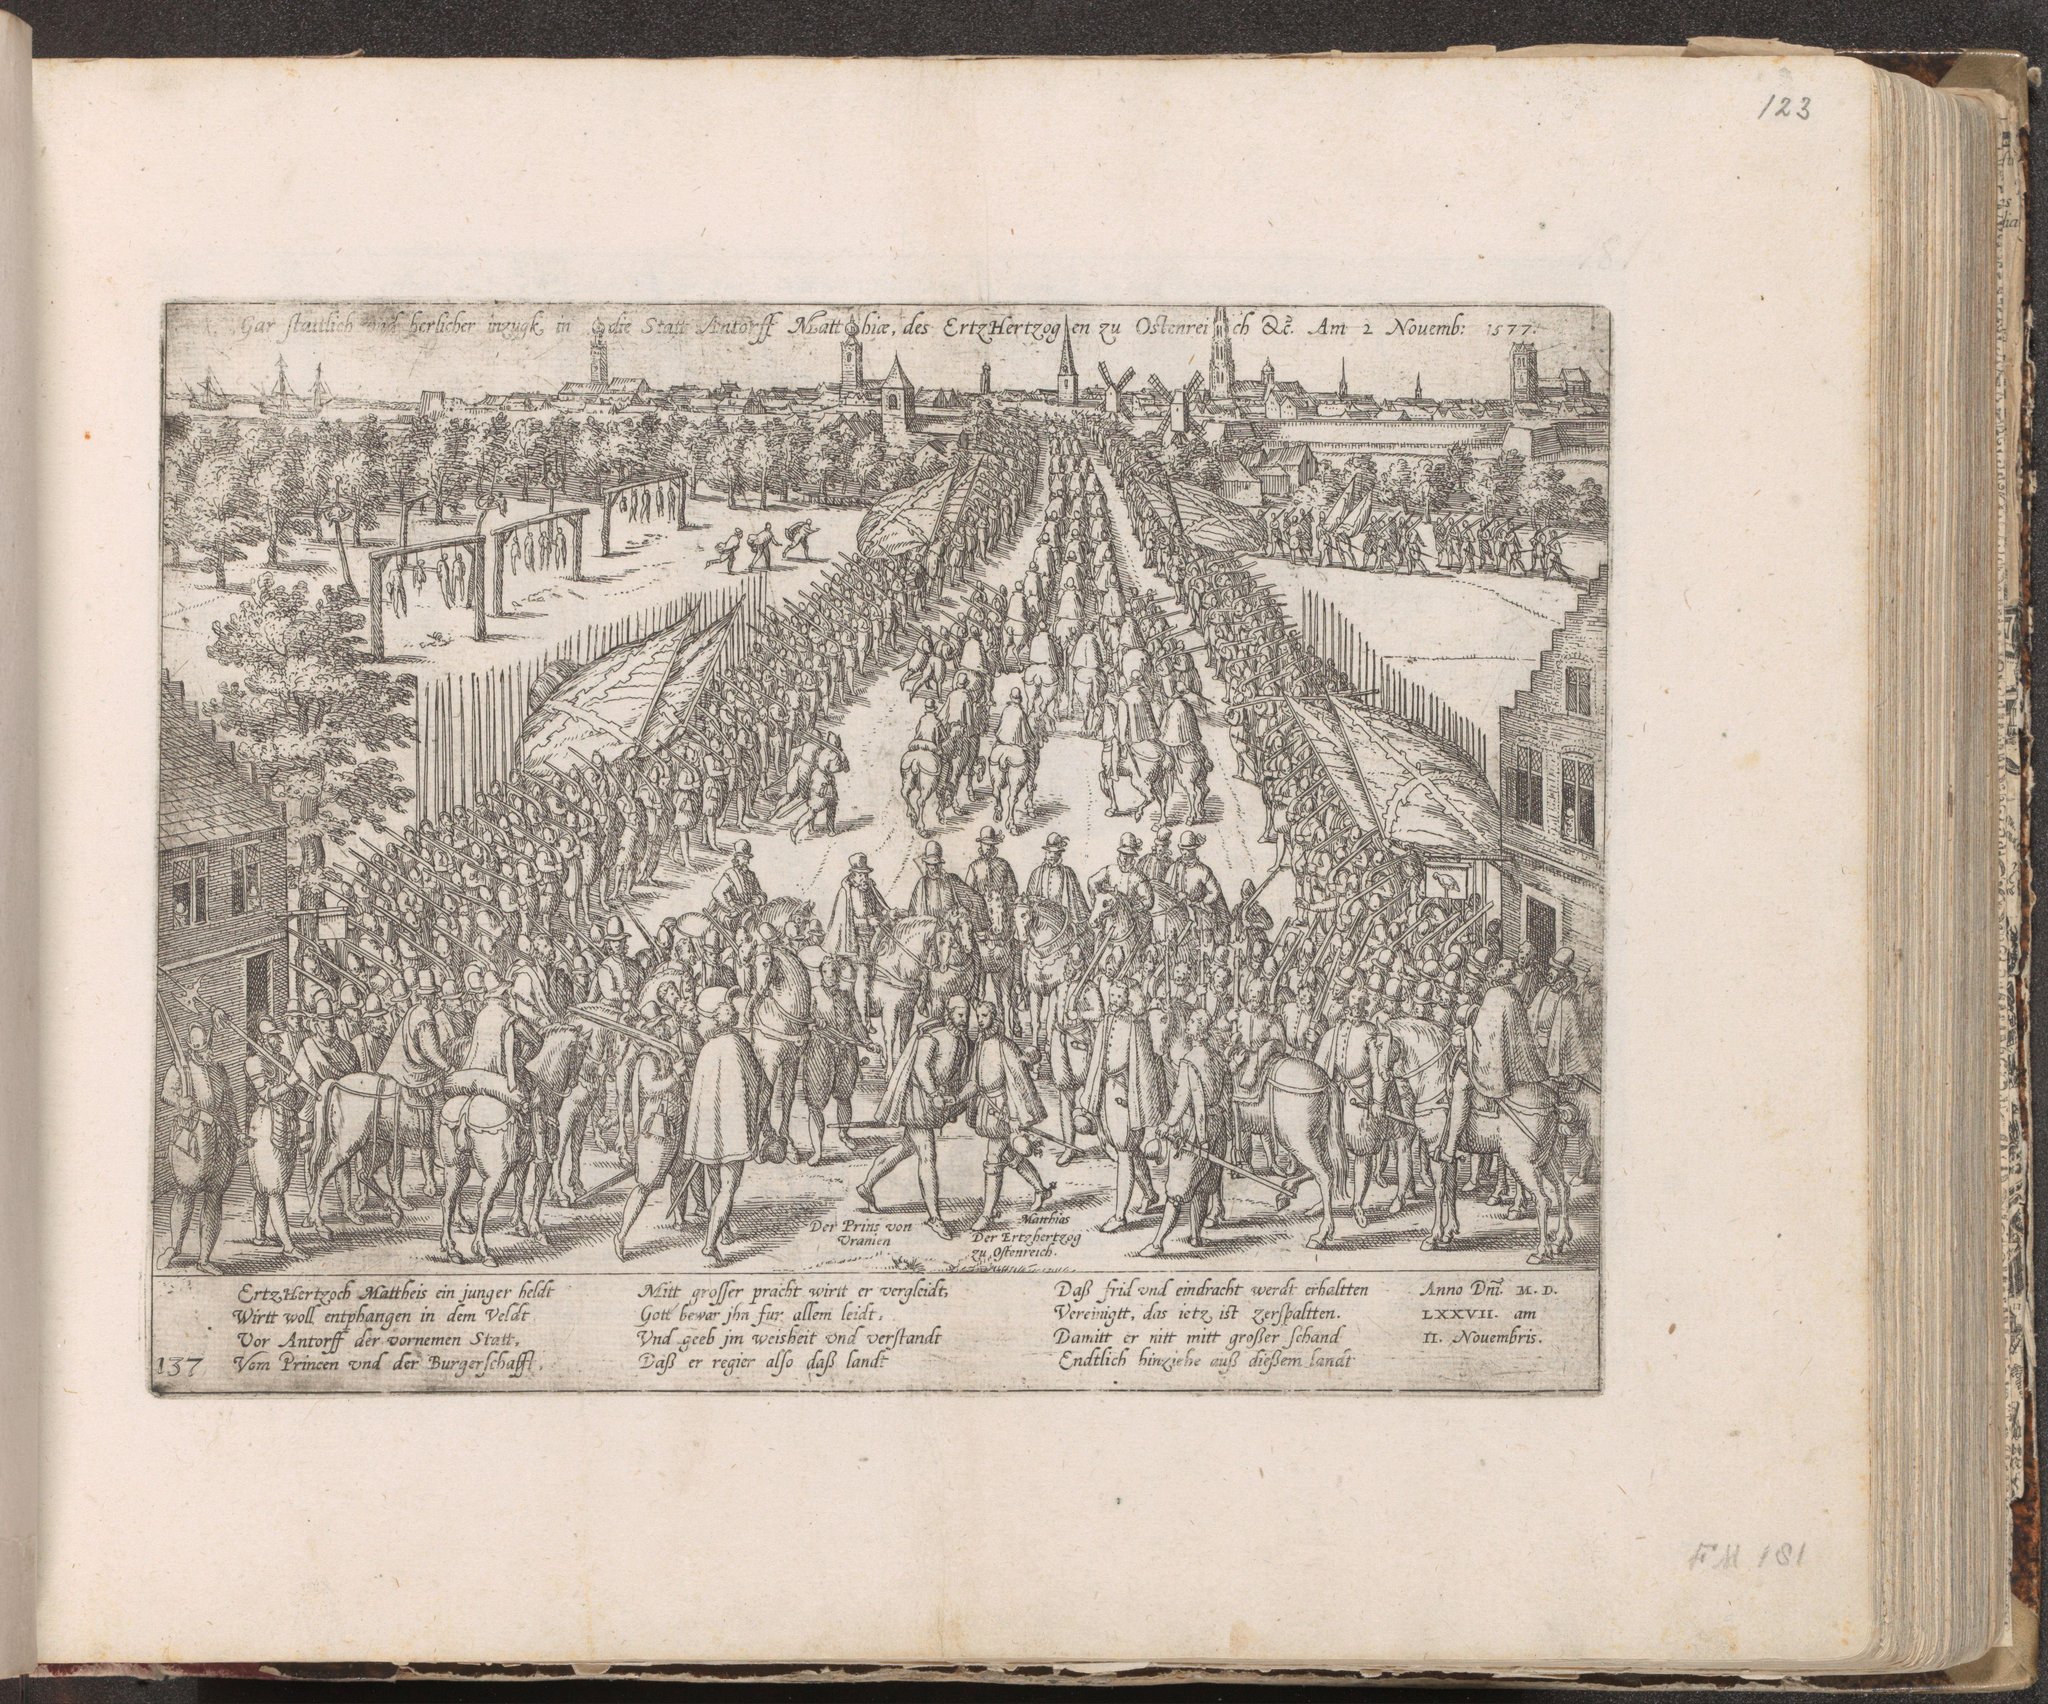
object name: history print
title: Serie 8: Nederlandse Gebeurtenissen, 1577-1583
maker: frans hogenberg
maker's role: print maker, publisher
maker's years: 1538-1590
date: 1581-1585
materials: paper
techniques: etching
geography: cologne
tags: vienna, matthias van oostenrijk (rooms-duits keizer), delft, william i (prince of orange), triumphal entry and public reception, pageant, 'entrée solennelle', 'joyeuse entrée', antwerp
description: Aankomst van aartshertog Matthias van Oostenrijk te Antwerpen, 21 november 1577. Matthias wordt verwelkomd door de prins van Oranje. De stoet trekt tussen hagen van soldaten langs het galgenveld naar de stad. Met onderschrift van 12 regels in het Duits. Linksonder genummerd: 137. De prent maakt deel uit van een album.